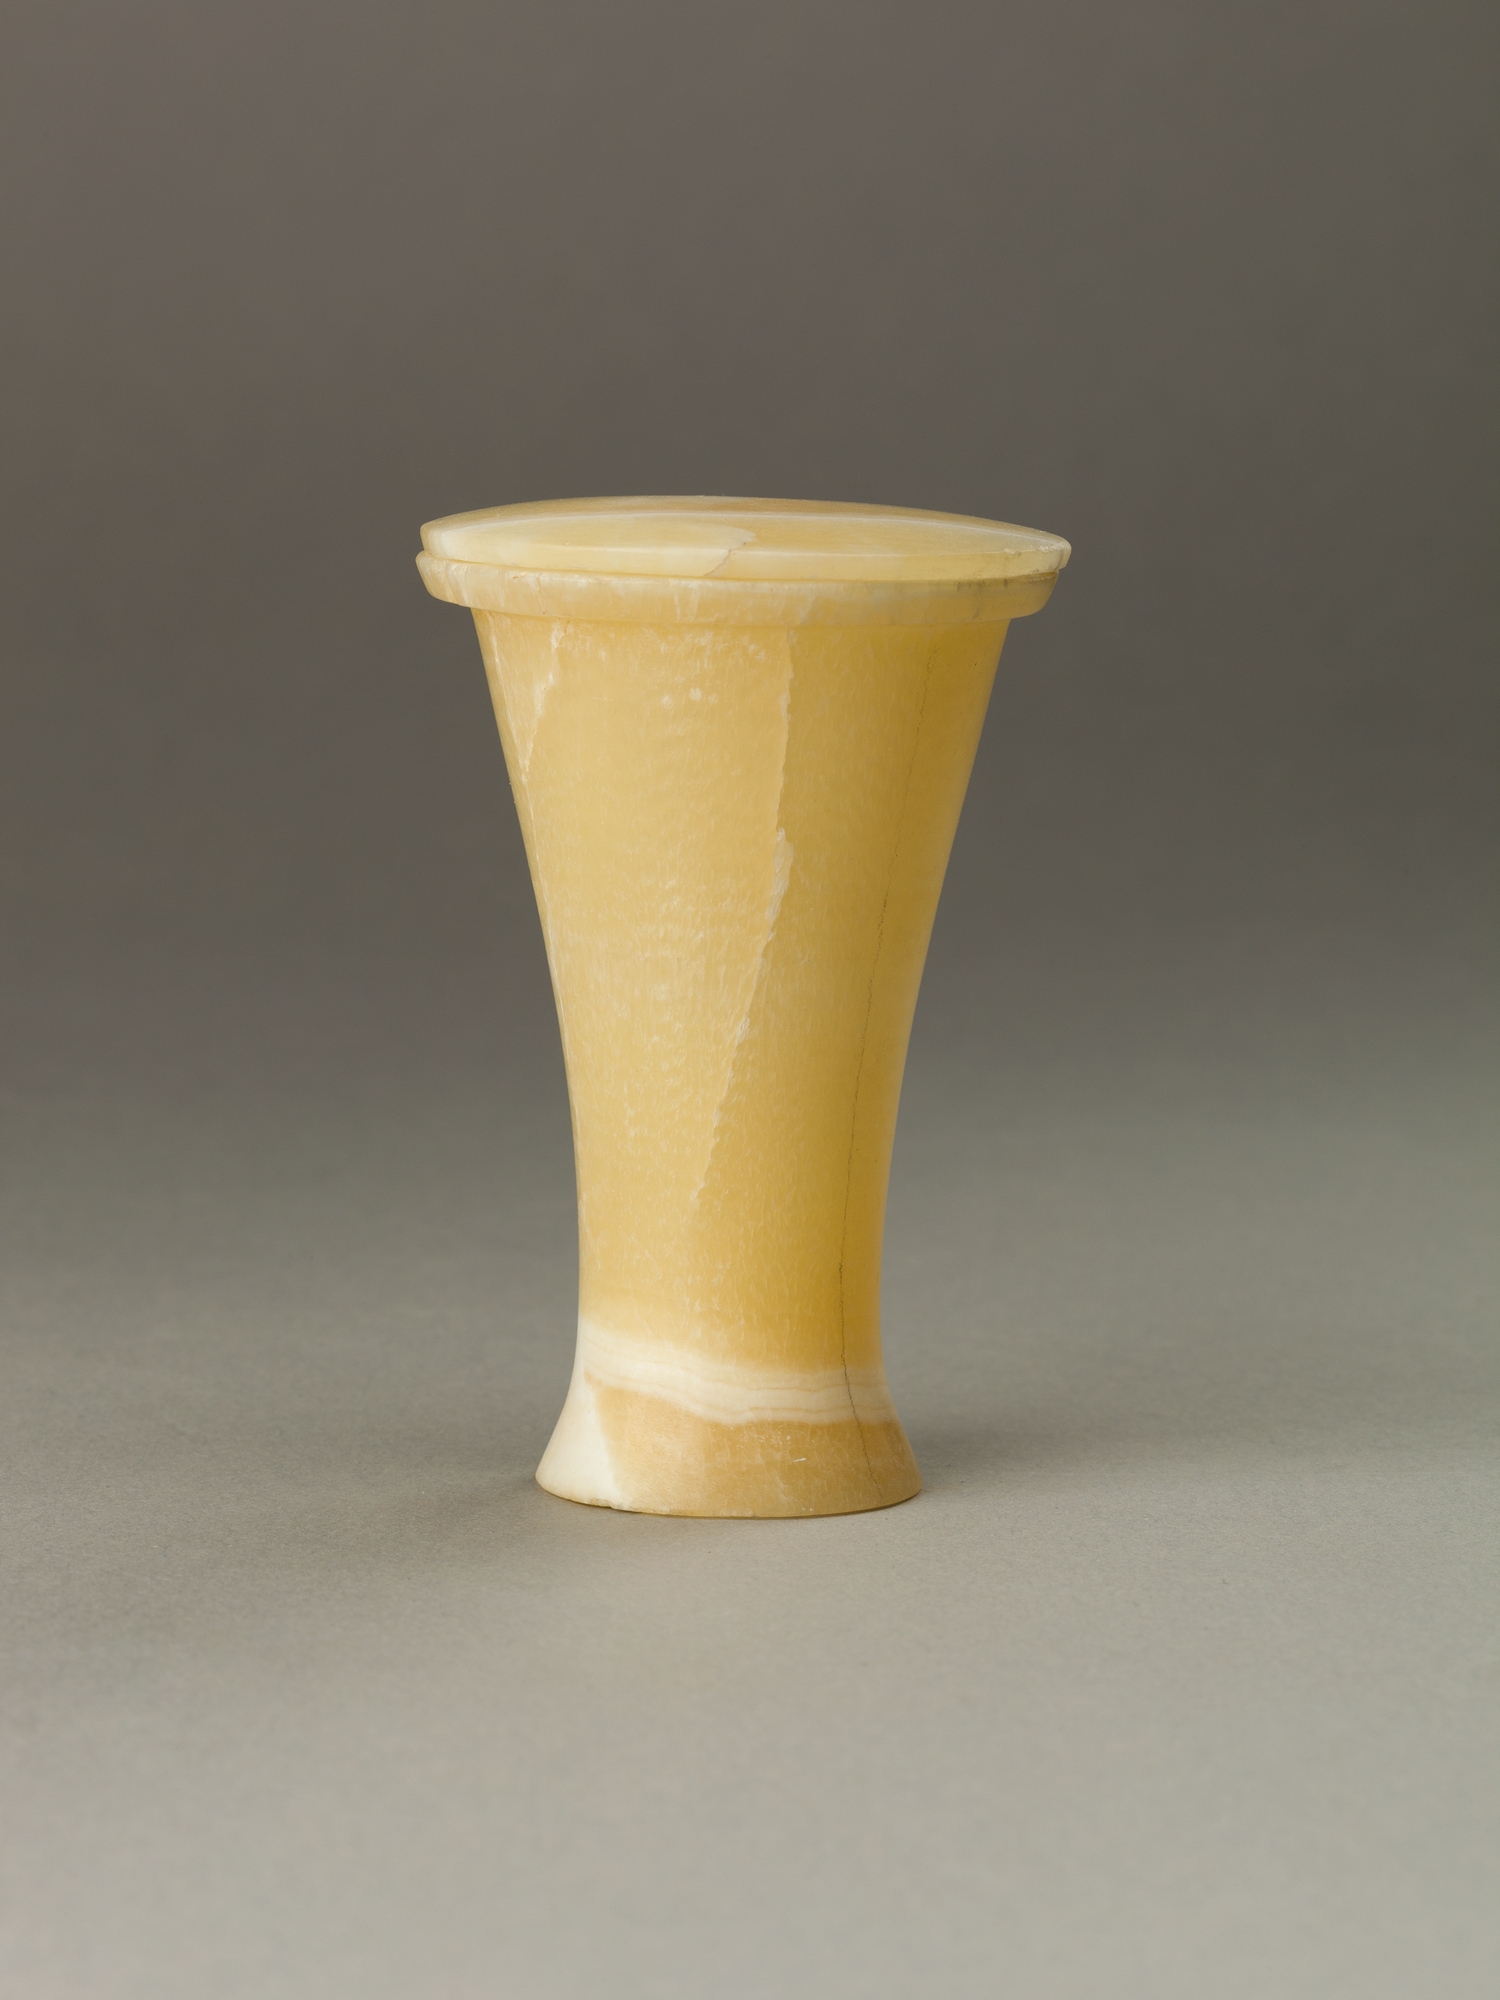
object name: ointment jar, lid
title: Ointment jar with lid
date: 1805 BCE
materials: stone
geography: egypt